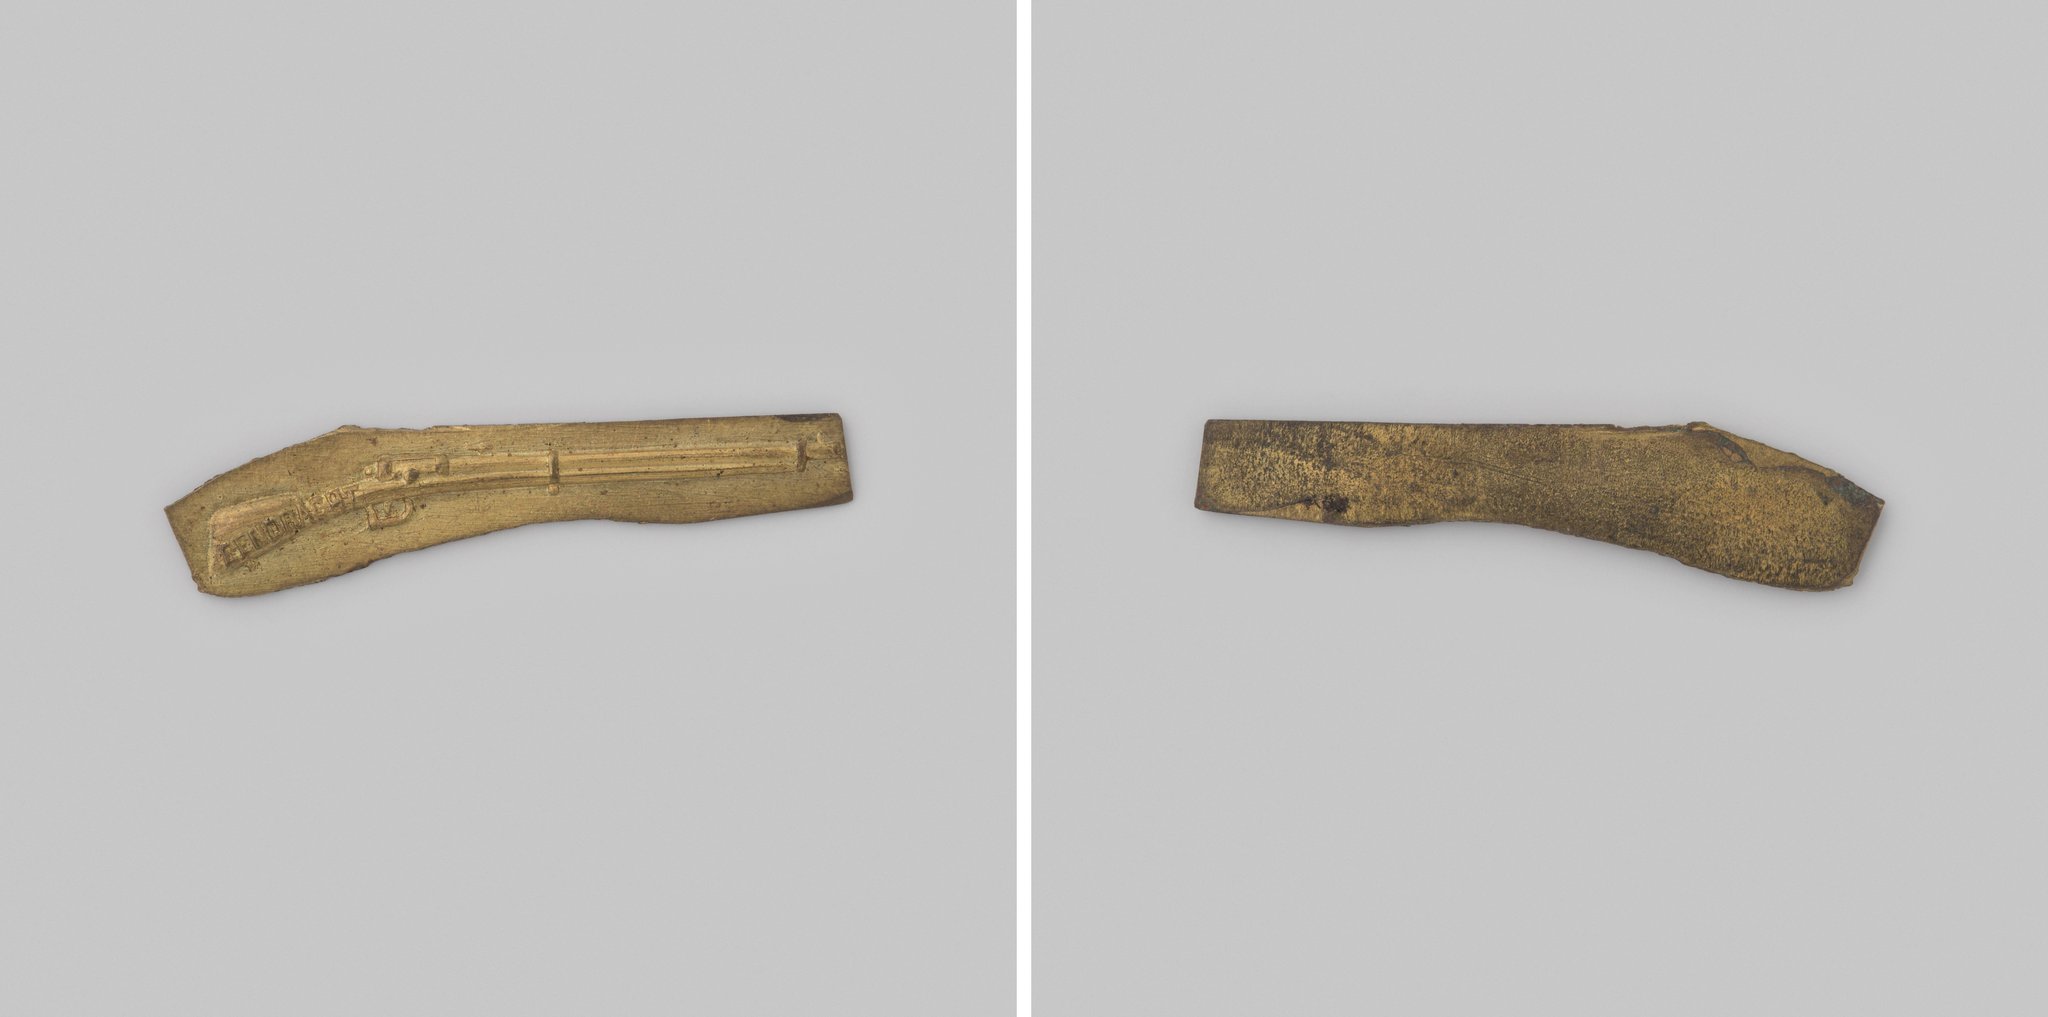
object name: medal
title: Draagteken van de vereniging Eendragt met een zilveren geweertje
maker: Anonymous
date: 1858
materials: silver